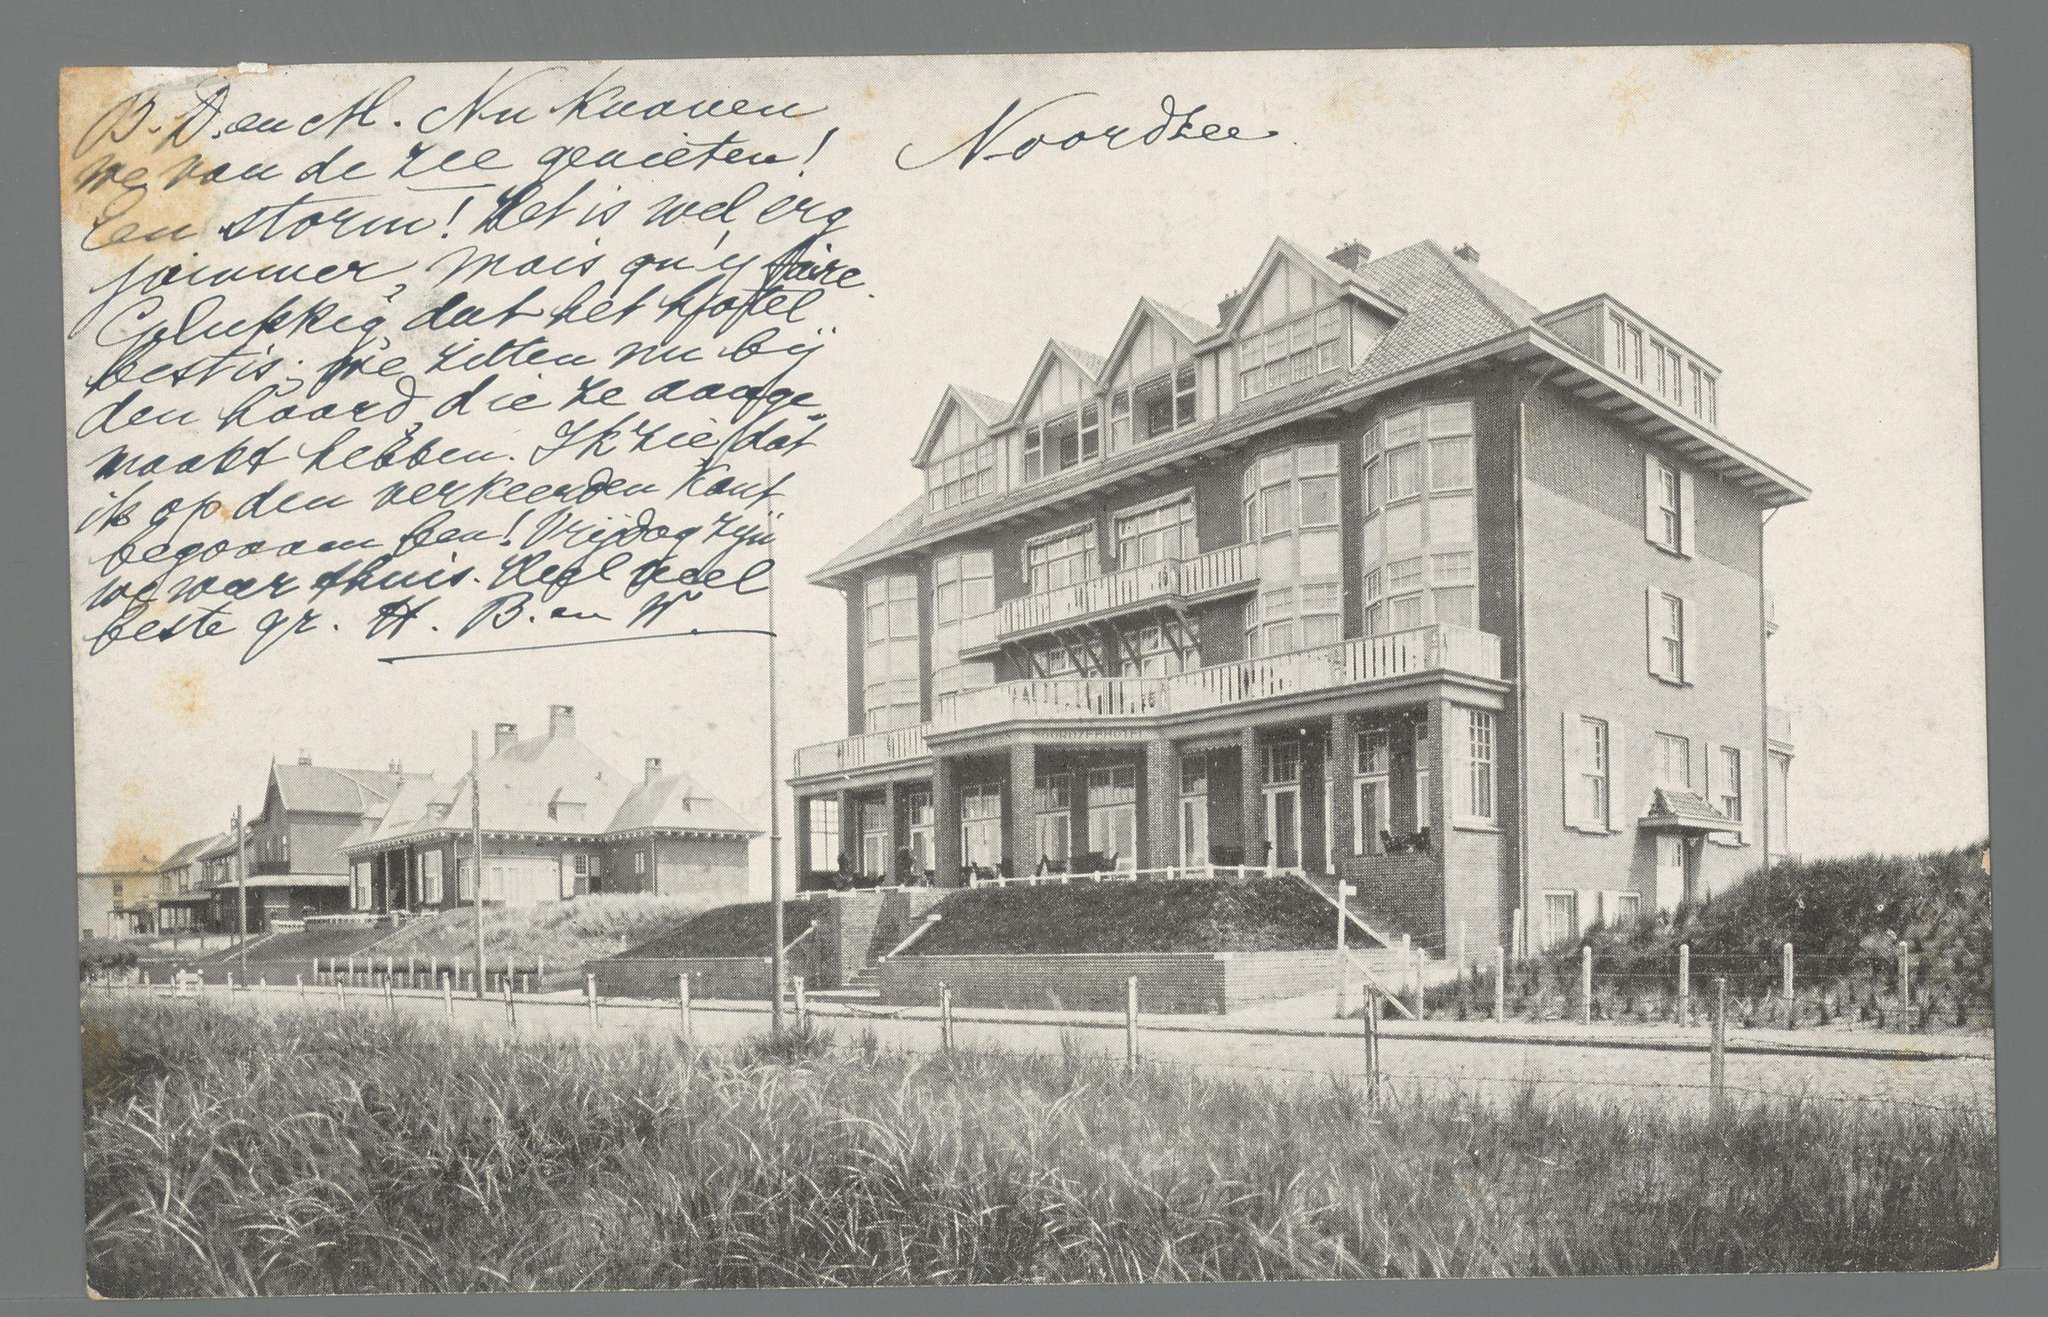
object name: ansichtkaart, prentbriefkaart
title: Noordzee Hotel te Zandvoort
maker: Anonymous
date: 1906-1916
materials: cardboard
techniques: writing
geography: zandvoort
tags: hotel, hostelry, inn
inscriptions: postage stamp